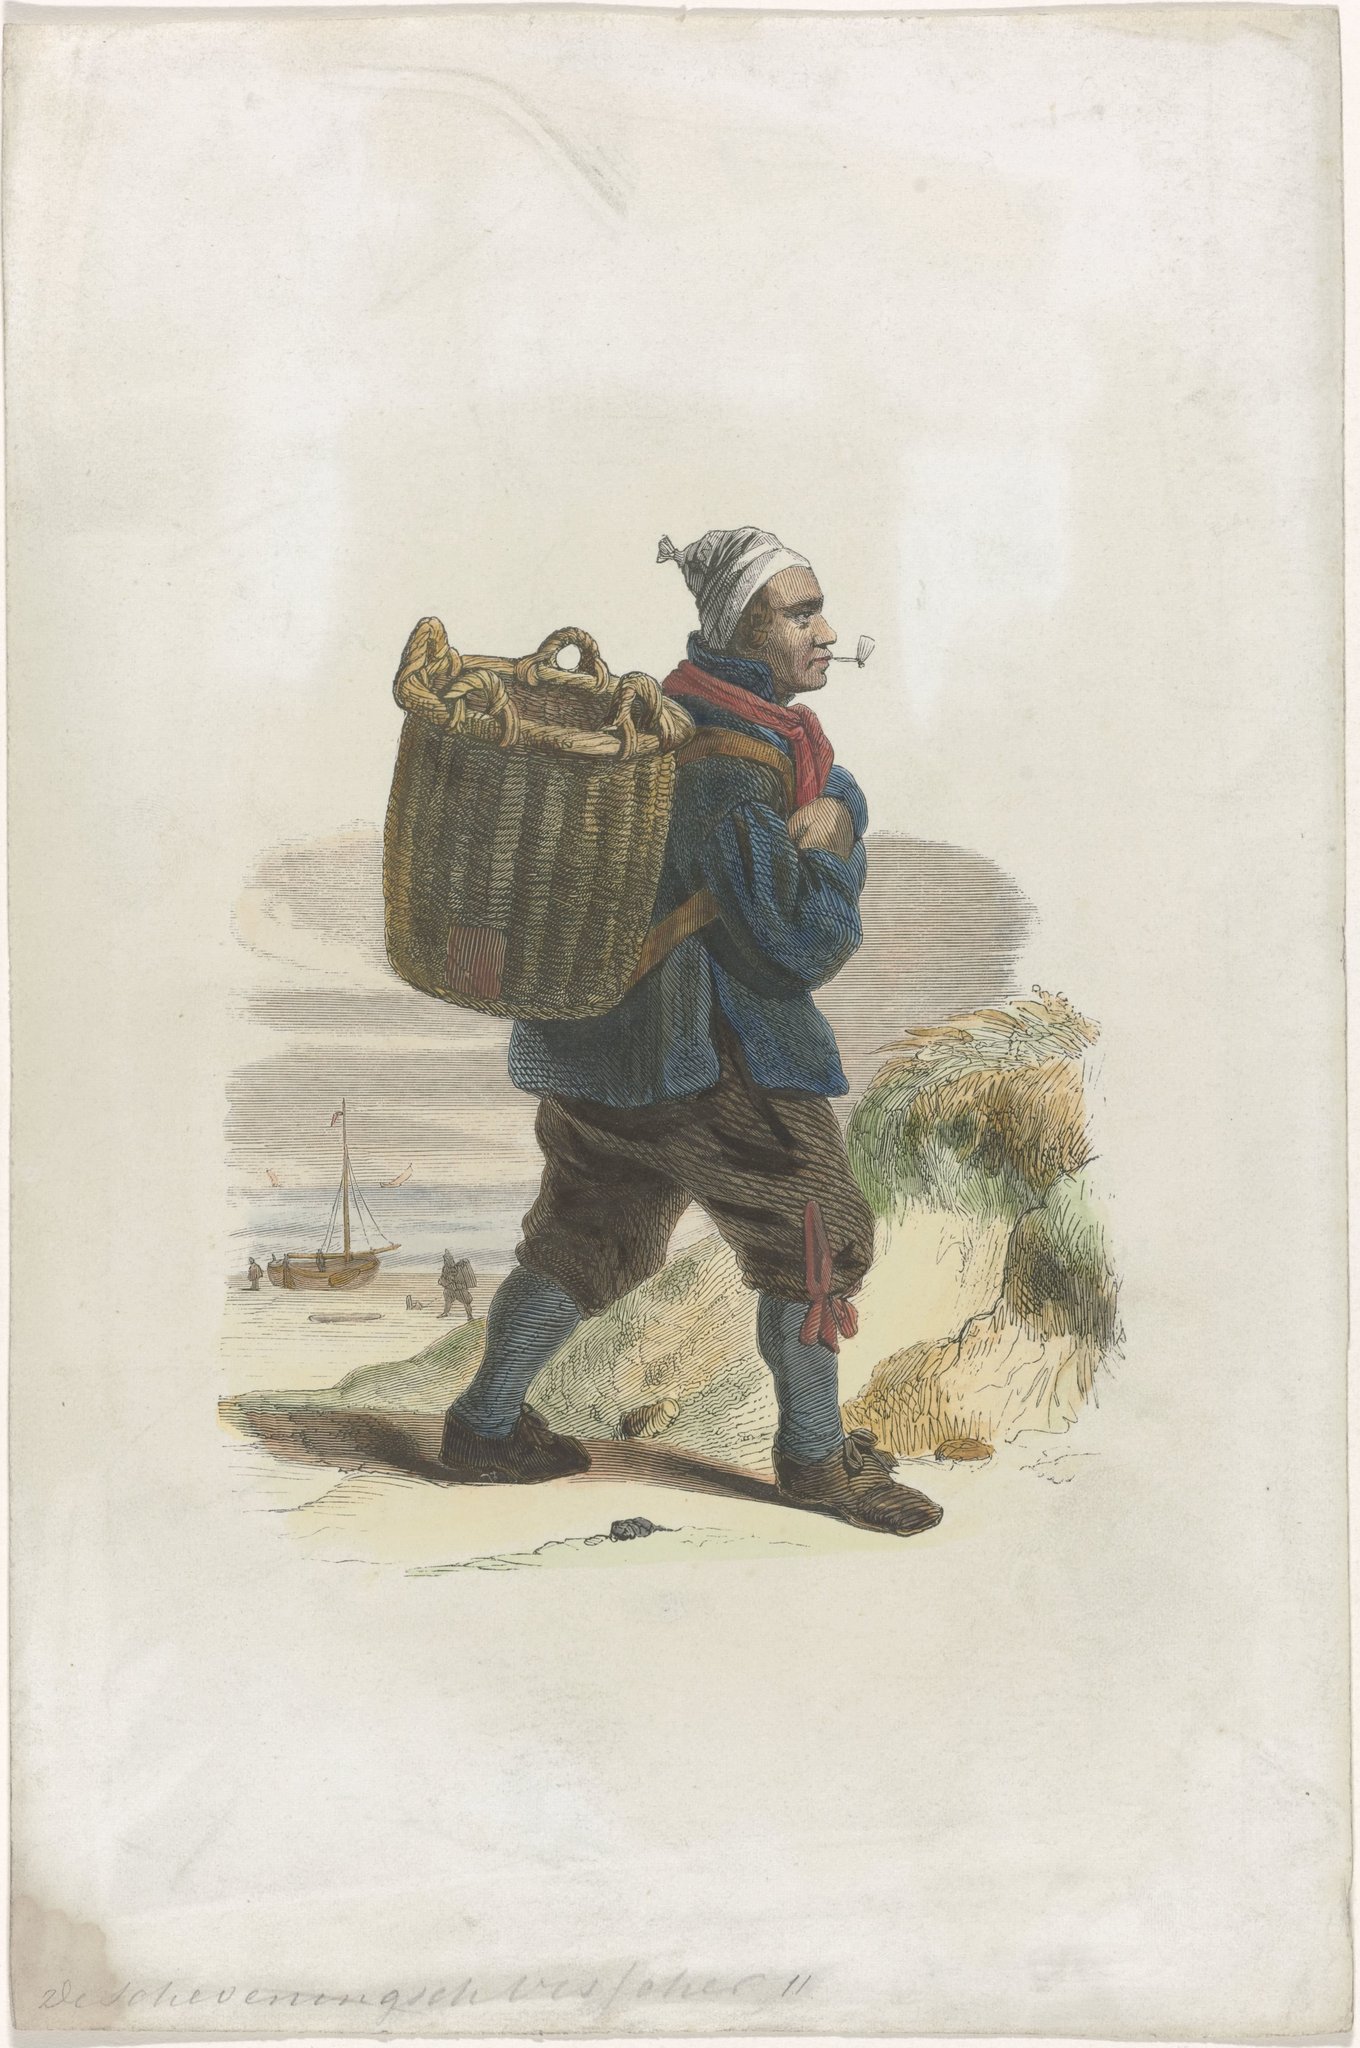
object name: print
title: De Scheveningse visser, 1840-1841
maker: henry brown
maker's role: print maker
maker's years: 1816-1870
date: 1840-1841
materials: paper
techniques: hand coloring, engraving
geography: netherlands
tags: professional clothes, fisherman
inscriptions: collector's mark: Lugt 2228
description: Gebruikt als illustratie in: De Nederlanden : karakterschetsen, kleederdrachten, houding en voorkomen van verschillende standen : tekst van de meest geachte schrijvers : met gravuren van Henry Brown naar teekeningen van de voornaamste Nederlandsche kunstenaars. 's Gravenhage, 1841.